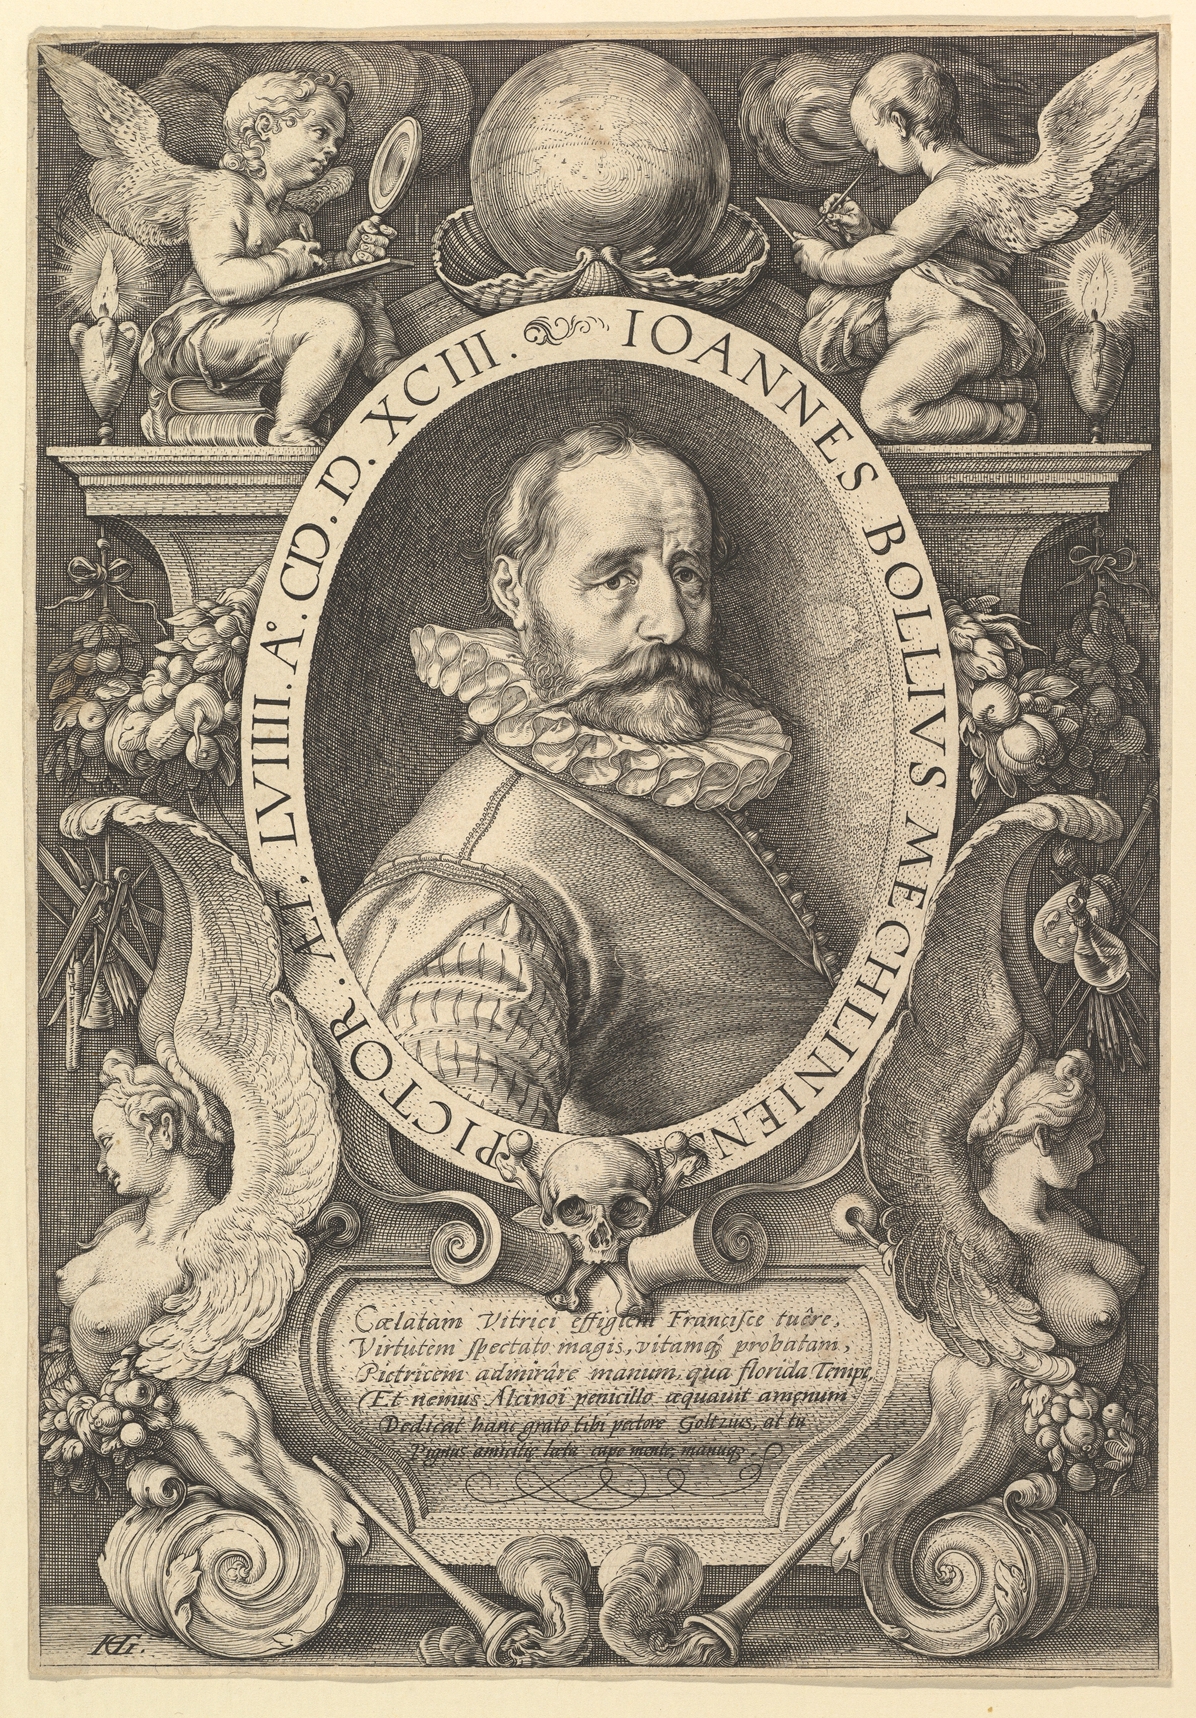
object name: print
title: Hans Bol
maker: hendrick goltzius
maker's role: artist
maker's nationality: netherlandish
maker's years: 1558-1617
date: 1593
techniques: engraving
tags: caryatids,men,portraits